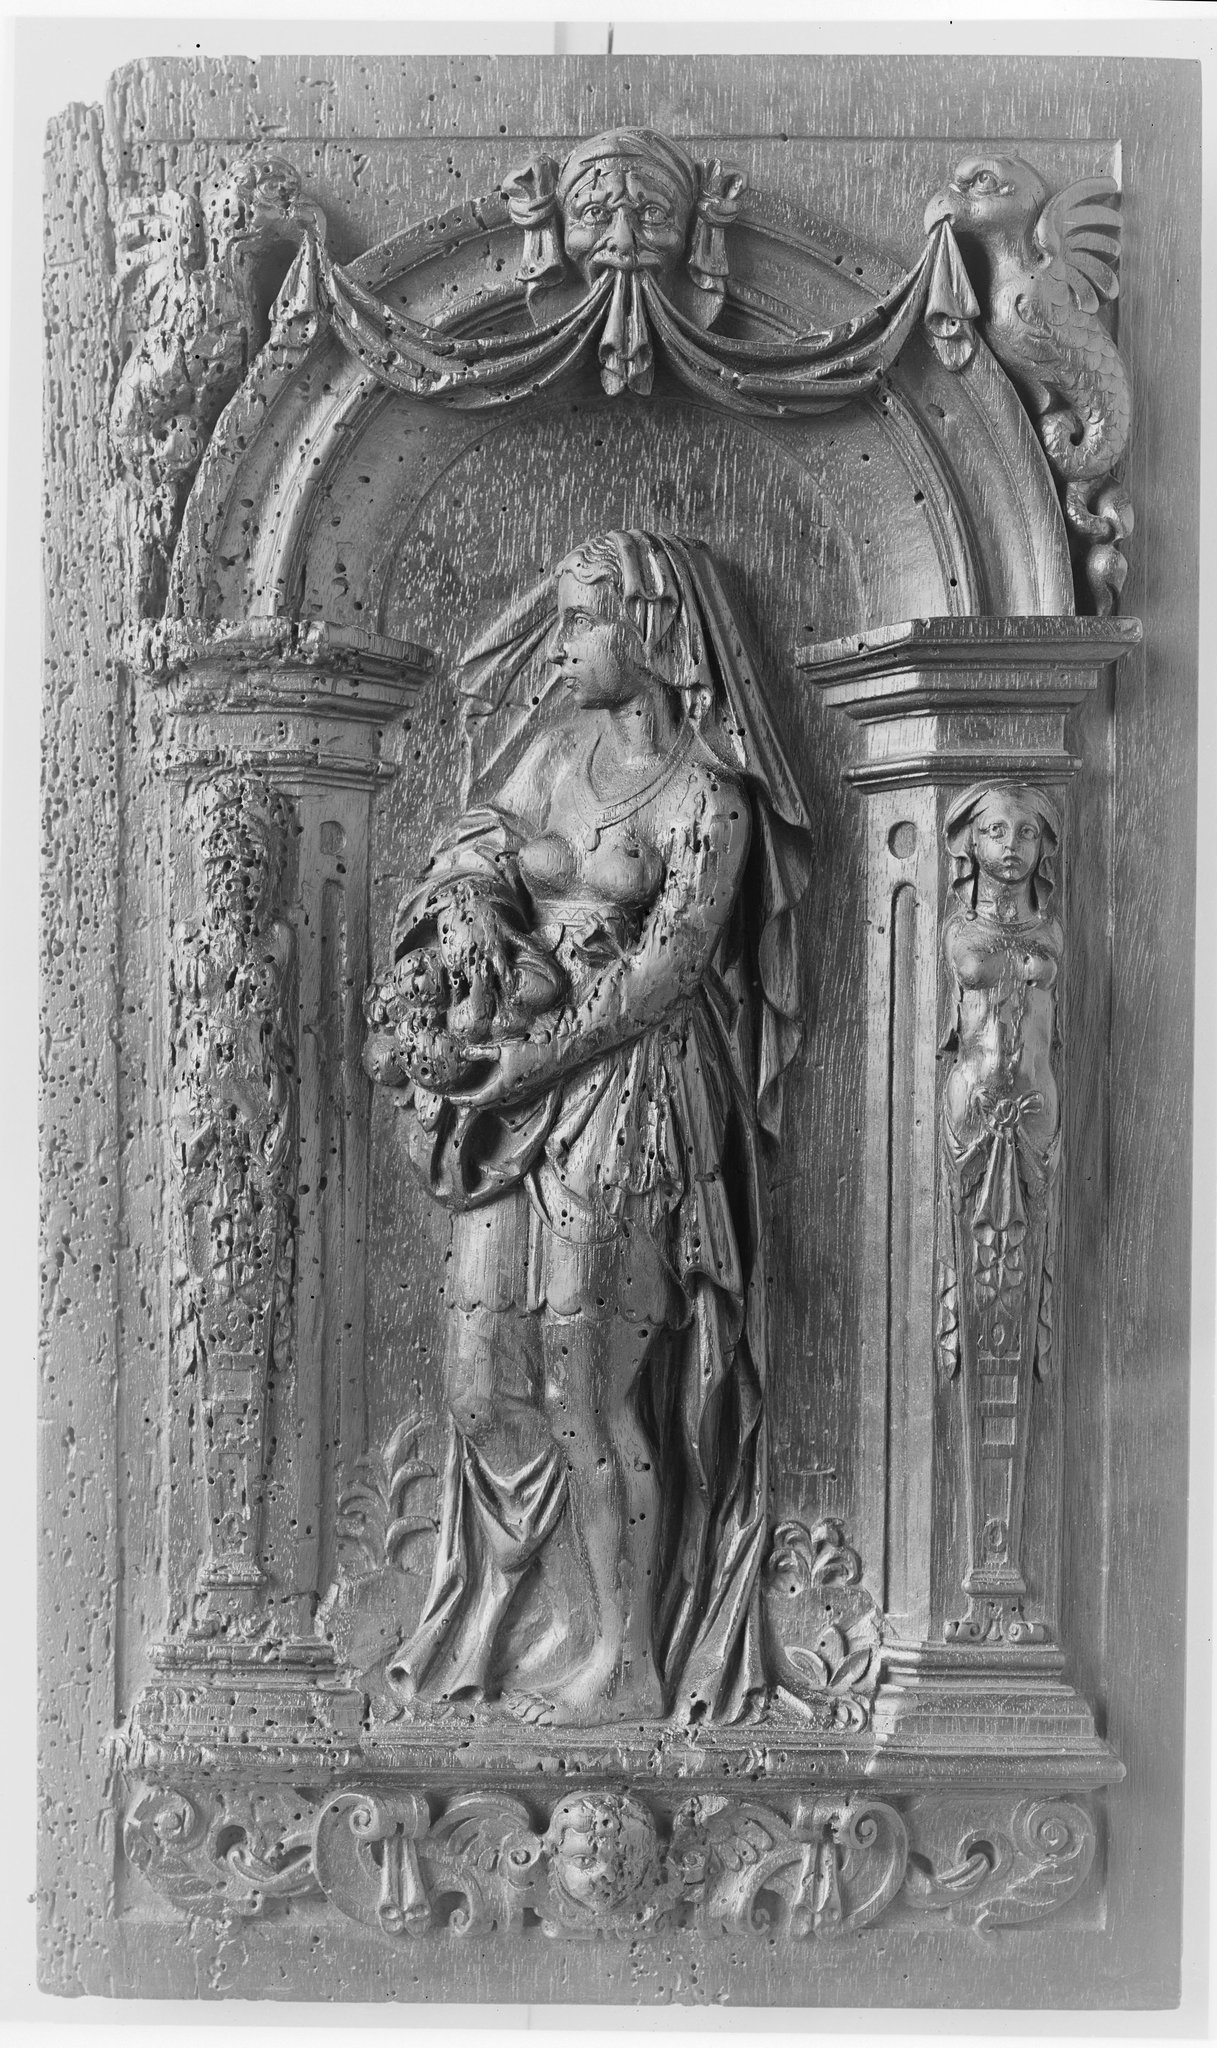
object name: panel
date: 1501-1600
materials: wood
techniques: carving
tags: grotesques,women